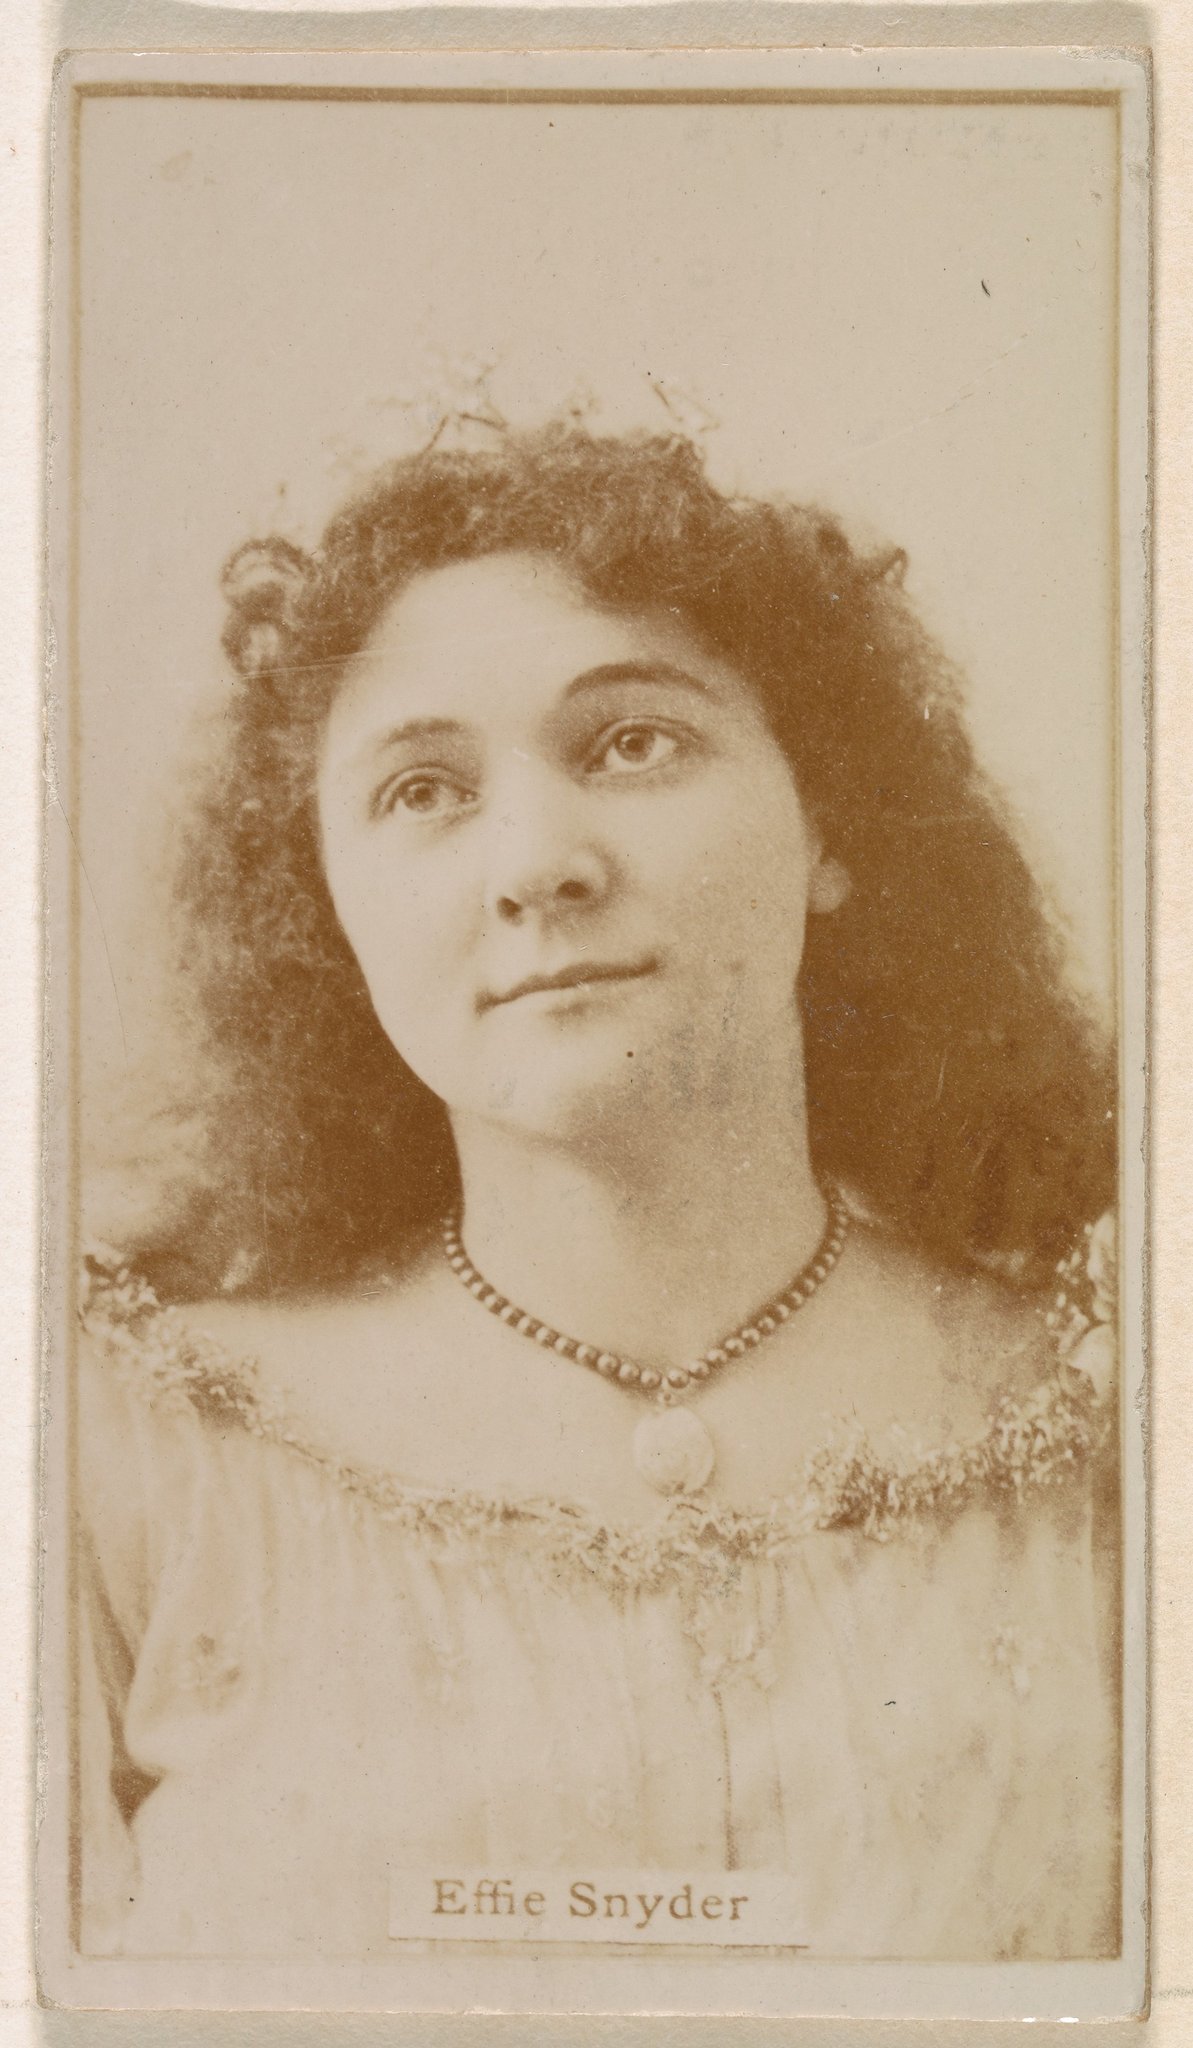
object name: photograph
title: Effie Snyder, from the Actresses series (N245) issued by Kinney Brothers to promote Sweet Caporal Cigarettes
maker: kinney brothers tobacco company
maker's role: publisher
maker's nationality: american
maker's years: 1869-2011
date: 1890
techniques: albumen silver print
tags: portraits,women,actresses